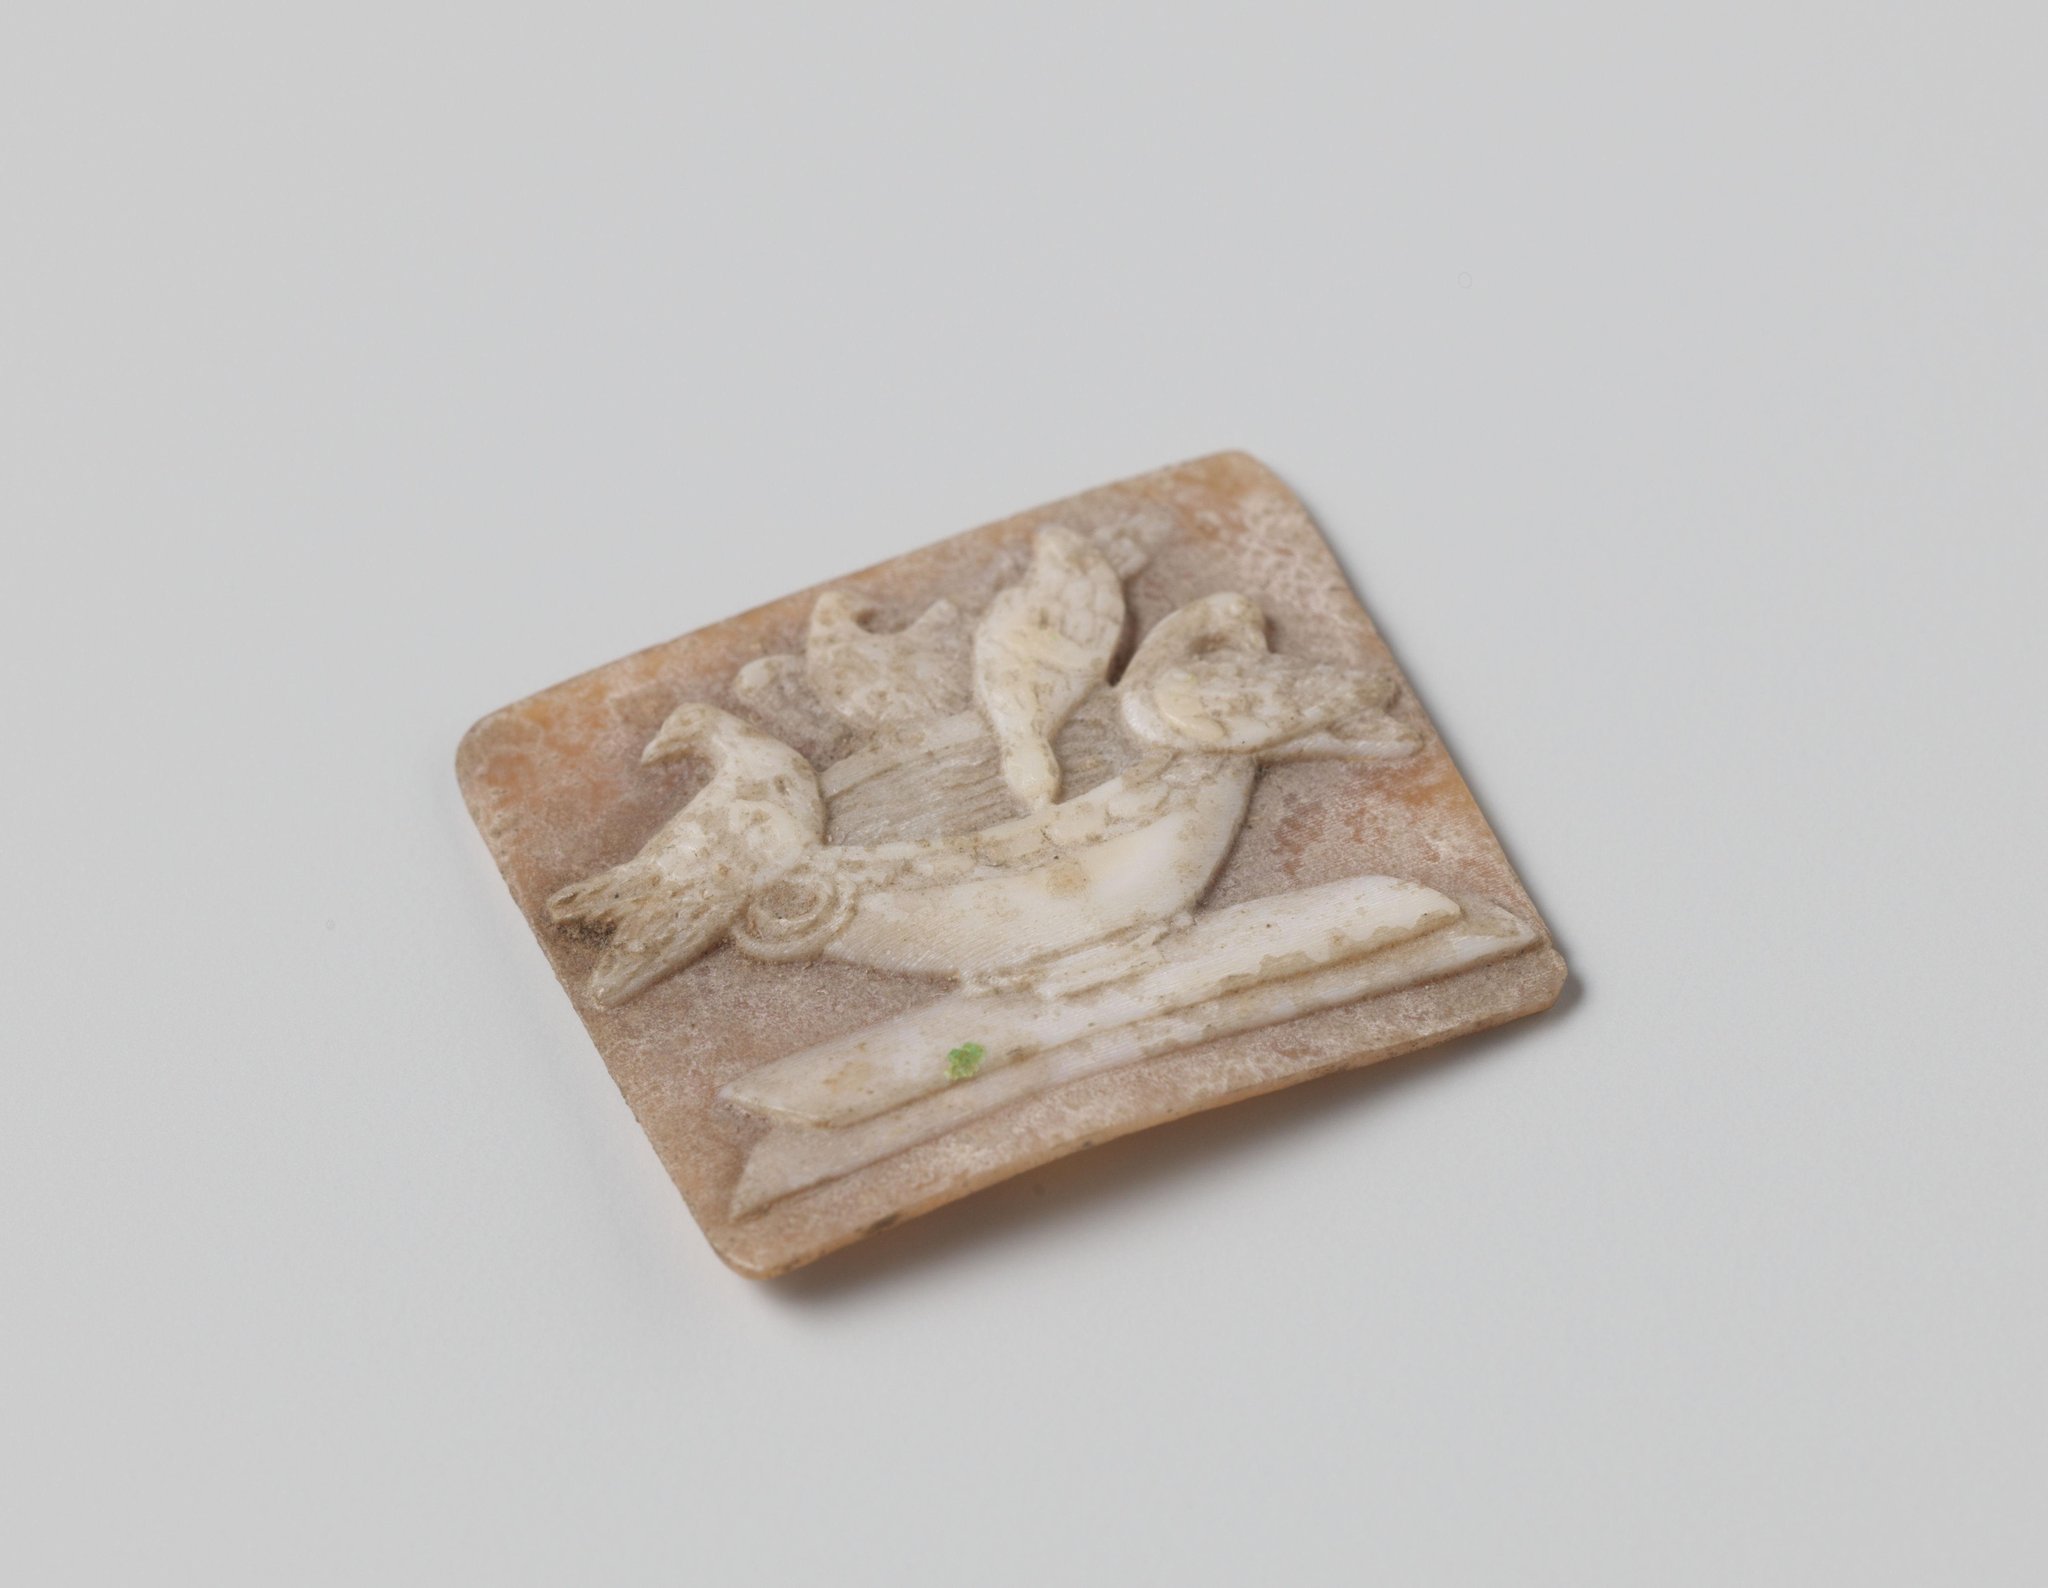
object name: miniature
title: Miniatuur bas-reliëf horend bij een poppenhuis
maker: Anonymous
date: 1400-1950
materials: stone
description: Bas-reliëf met vier vogels zittend op een kom waarvan er een drinkt.